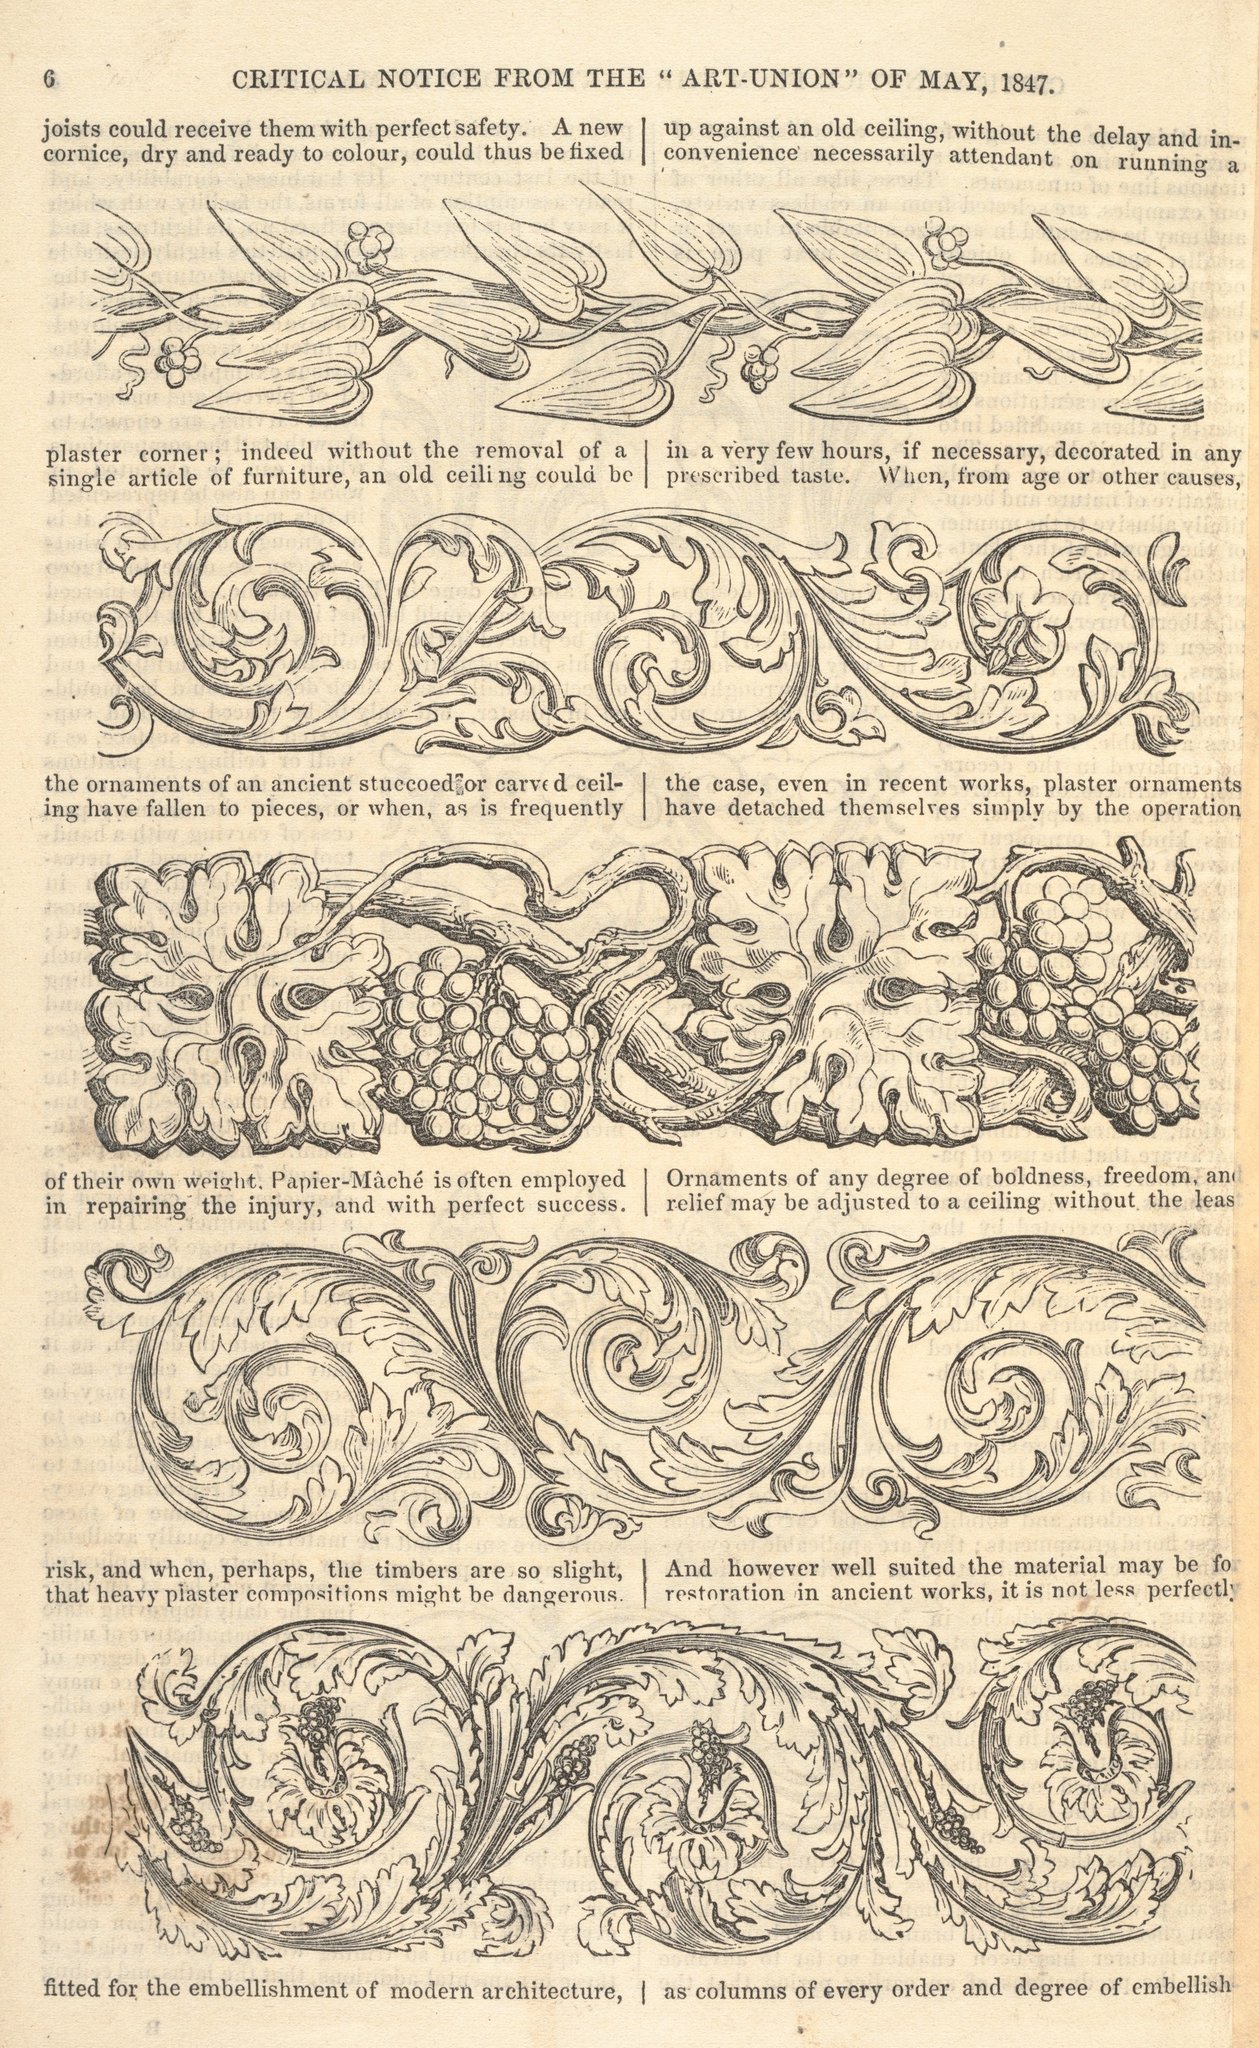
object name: book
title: Illustrated Tariff of the Improved Papier-Mâché Picture Frames, also, Enriched Mouldings, made by machinery in twelve feet lengths, without join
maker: charles frederick bielefeld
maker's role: author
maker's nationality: british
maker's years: 1836-1850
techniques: lithograph, engraving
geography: england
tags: ornament,grapes,leaves,vines